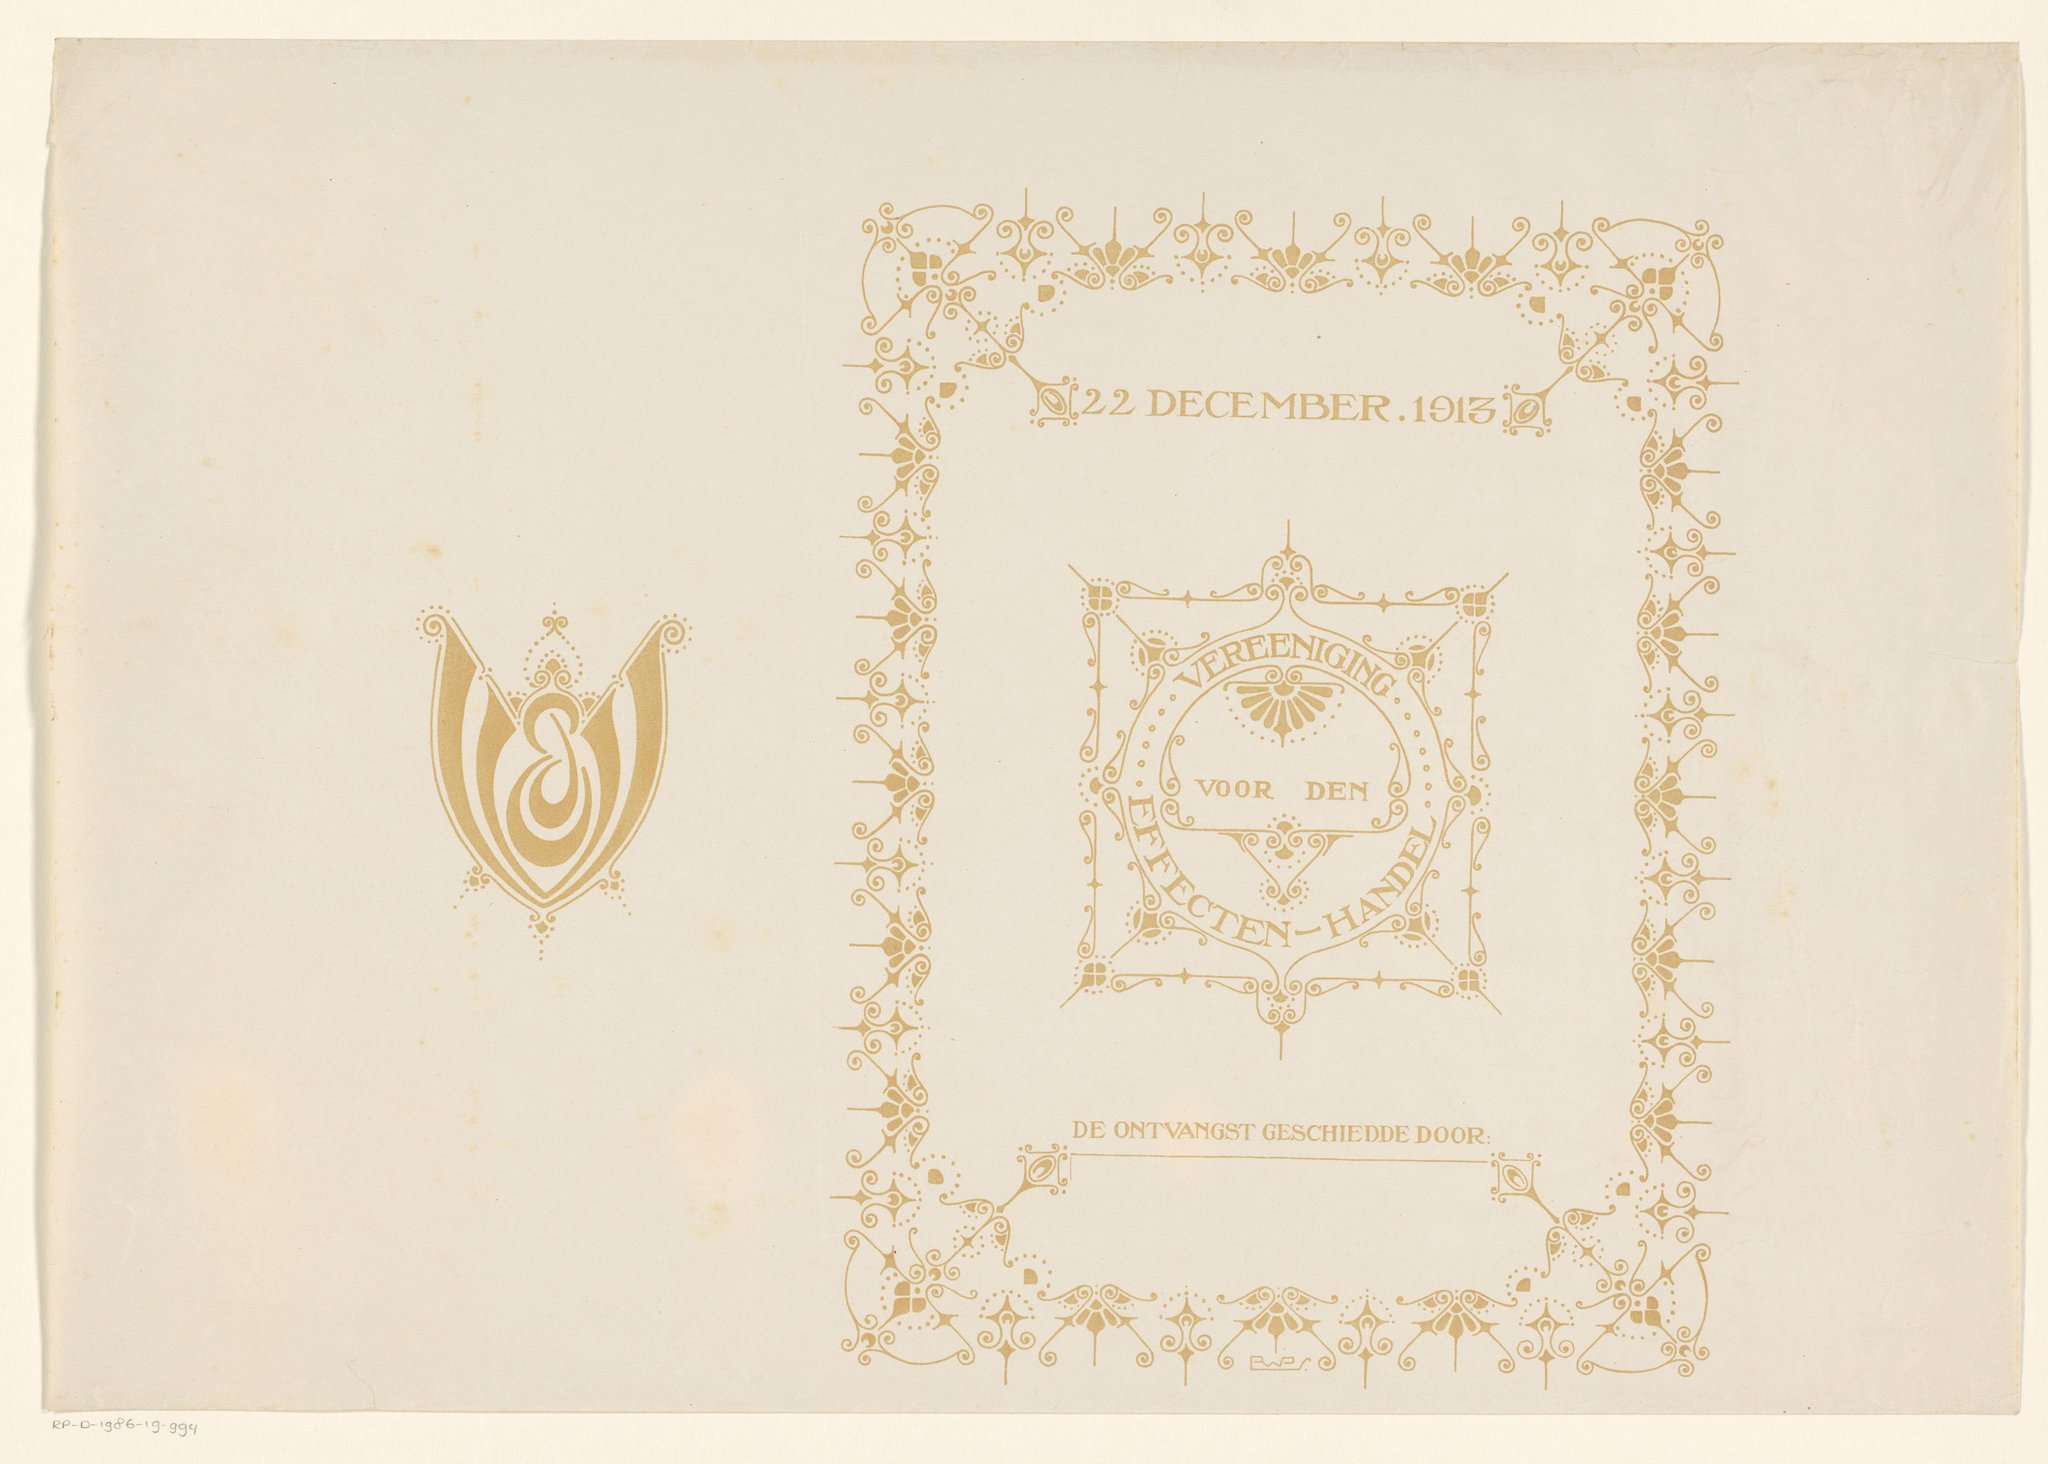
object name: design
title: Ontwerp met bladdecoratie voor de Vereeniging voor den Effectenhandel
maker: reinier willem petrus de vries (1874-1953)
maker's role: draughtsman, print maker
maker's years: 1874-1953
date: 1913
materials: paper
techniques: lithograph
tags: flowers ~ ornament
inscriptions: collector's mark: ‘R:MVS.’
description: Ontwerp, mogelijk voor een album of omslag, met links het beeldmerk van de vereniging en rechts een rechthoekig kader met bloemornamenten met daarin een vierkant kader met tekst en bloemornamenten.